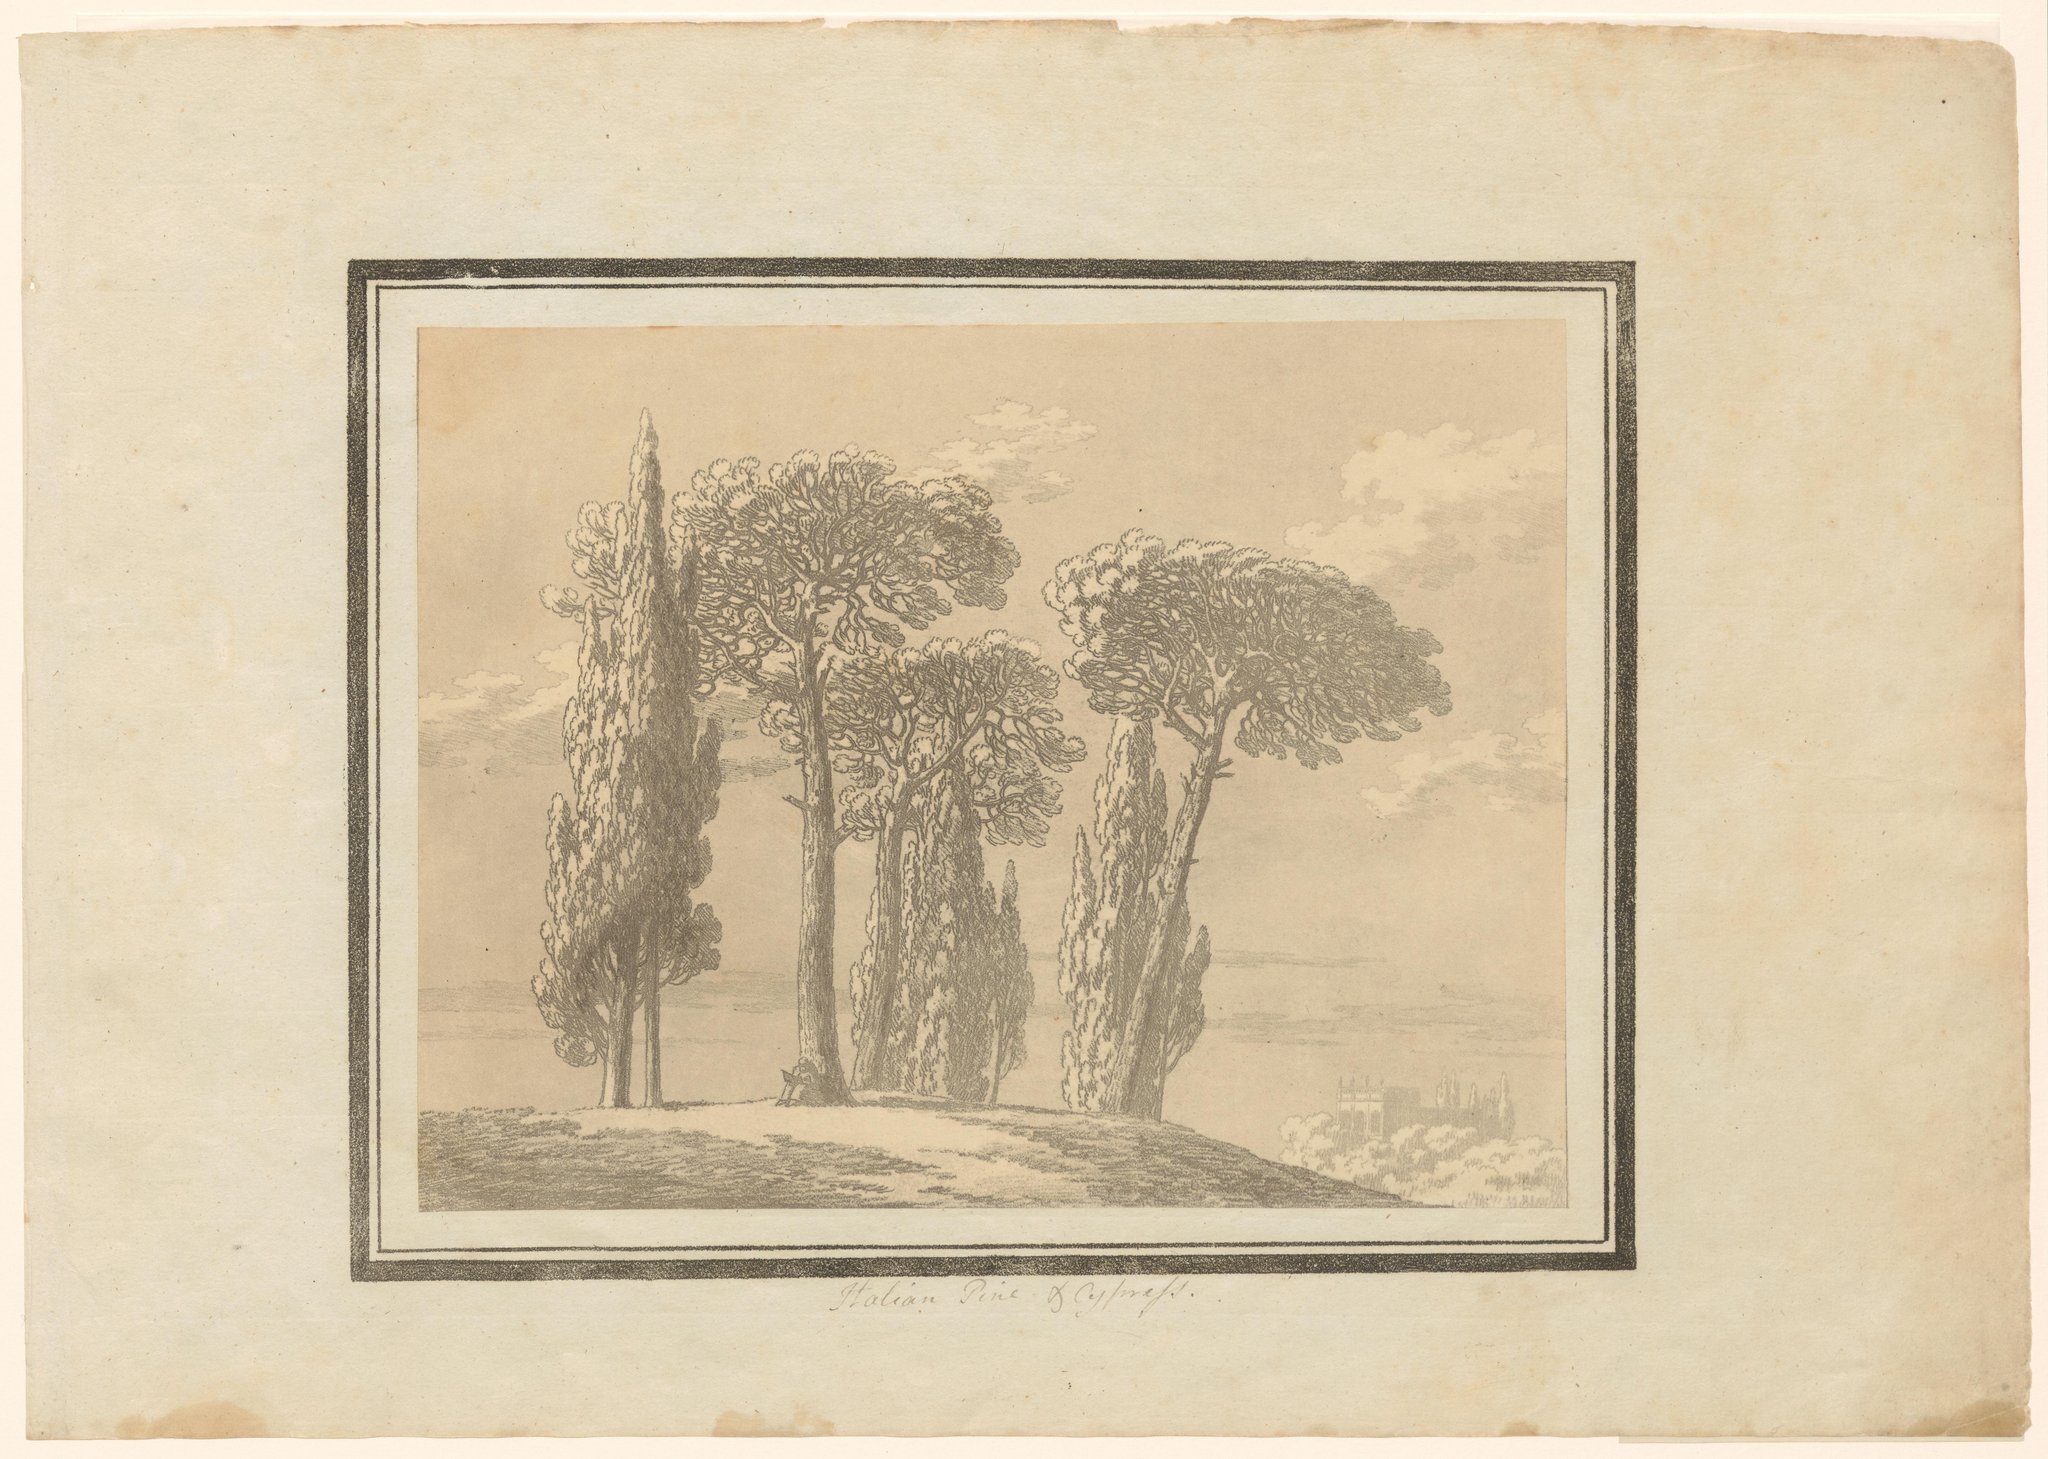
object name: print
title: Italian Pine & Cypress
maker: john robert cozens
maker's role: draughtsman, print maker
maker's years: 1752-1797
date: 1789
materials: paper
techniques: aquatint, soft ground etching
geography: london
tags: trees: cypress, trees: pine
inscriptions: title: ‘Italian Pine & Cypress.’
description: Well-travelled contemporaries would have recognised the pine and cypress. They grew in the gardens of Villa Negroni near Rome, where Cozens was one of many artists who sketched the grounds. No surprise then to see a colleague at work, sitting by a tree. Here too, the yellowed paper conveys the Mediterranean atmosphere.